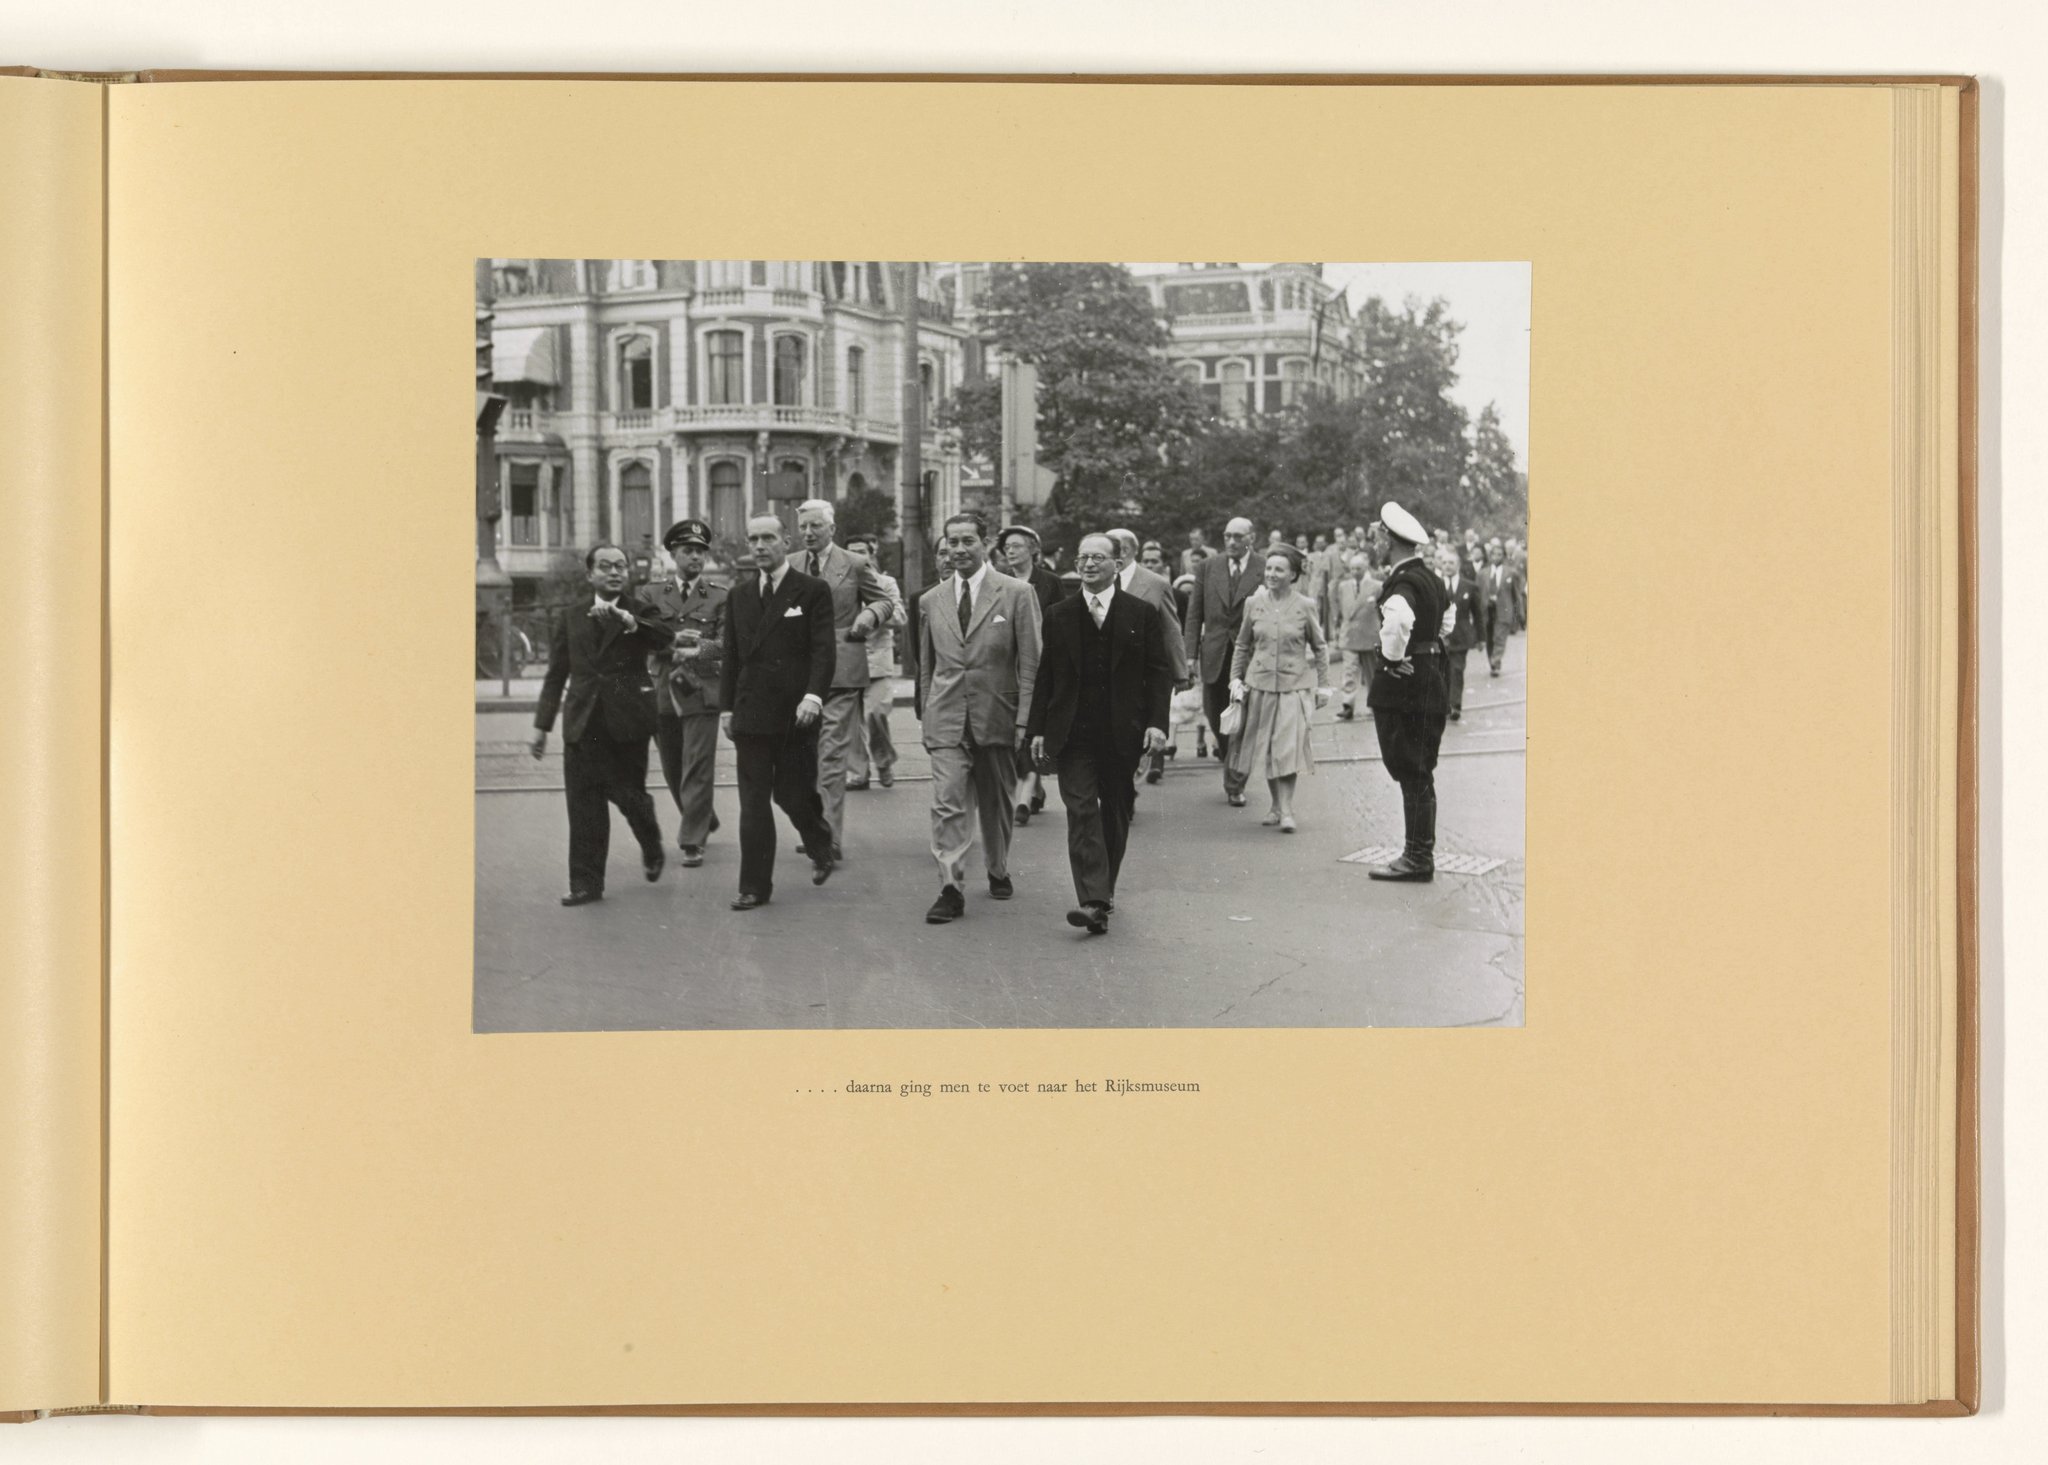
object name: photograph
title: .... daarna ging men te voet naar het Rijksmuseum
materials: paper, photographic support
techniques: gelatin silver print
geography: amsterdam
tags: utrecht, mohammad hatta, amsterdam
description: Het gezelschap onderweg van het Stedelijk Museum naar het Rijksmuseum. Links Mohammed Hatta met de directeur van het Rijksmuseum David Röell. Foto in het fotoalbum met 37 foto's van de rondetafelconferentie gehouden tussen 23 augustus en 2 november in Den Haag in 1949 tussen vertegenwoordigers van Nederland, de Republiek Indonesië en de Bijeenkomst Federaal Overleg. Het exemplaar aangeboden aan premier Willem Drees.